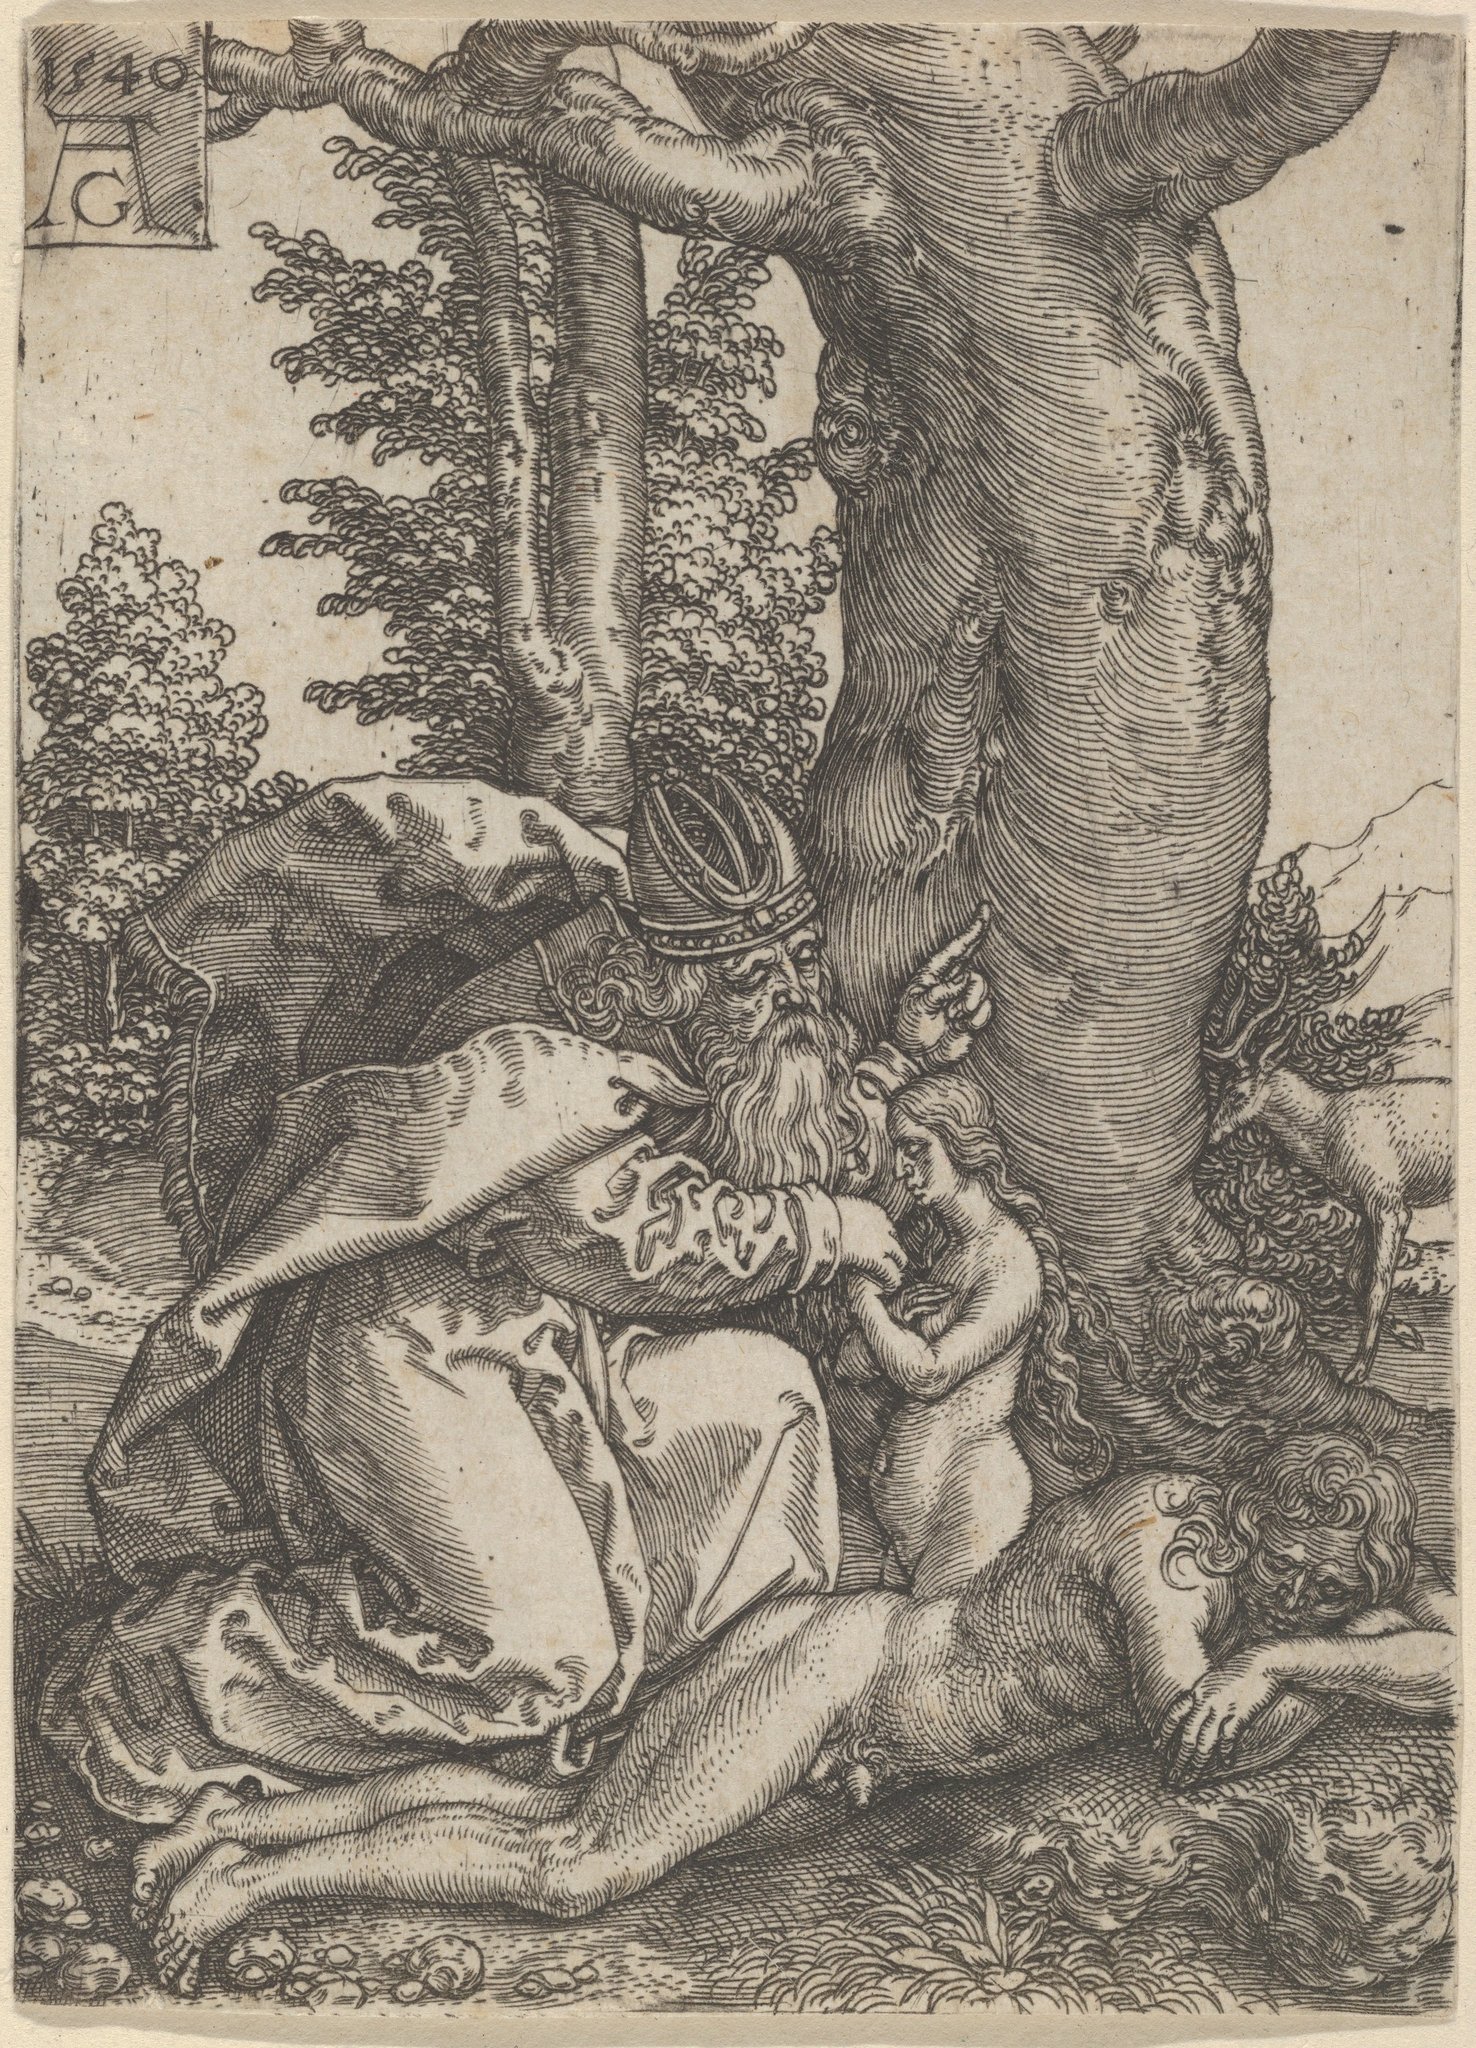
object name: print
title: The Creation of Eve, from The Story of Adam and Eve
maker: heinrich aldegrever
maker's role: artist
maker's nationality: german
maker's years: 1502-1561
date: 1540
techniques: engraving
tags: men,trees,adam,eve